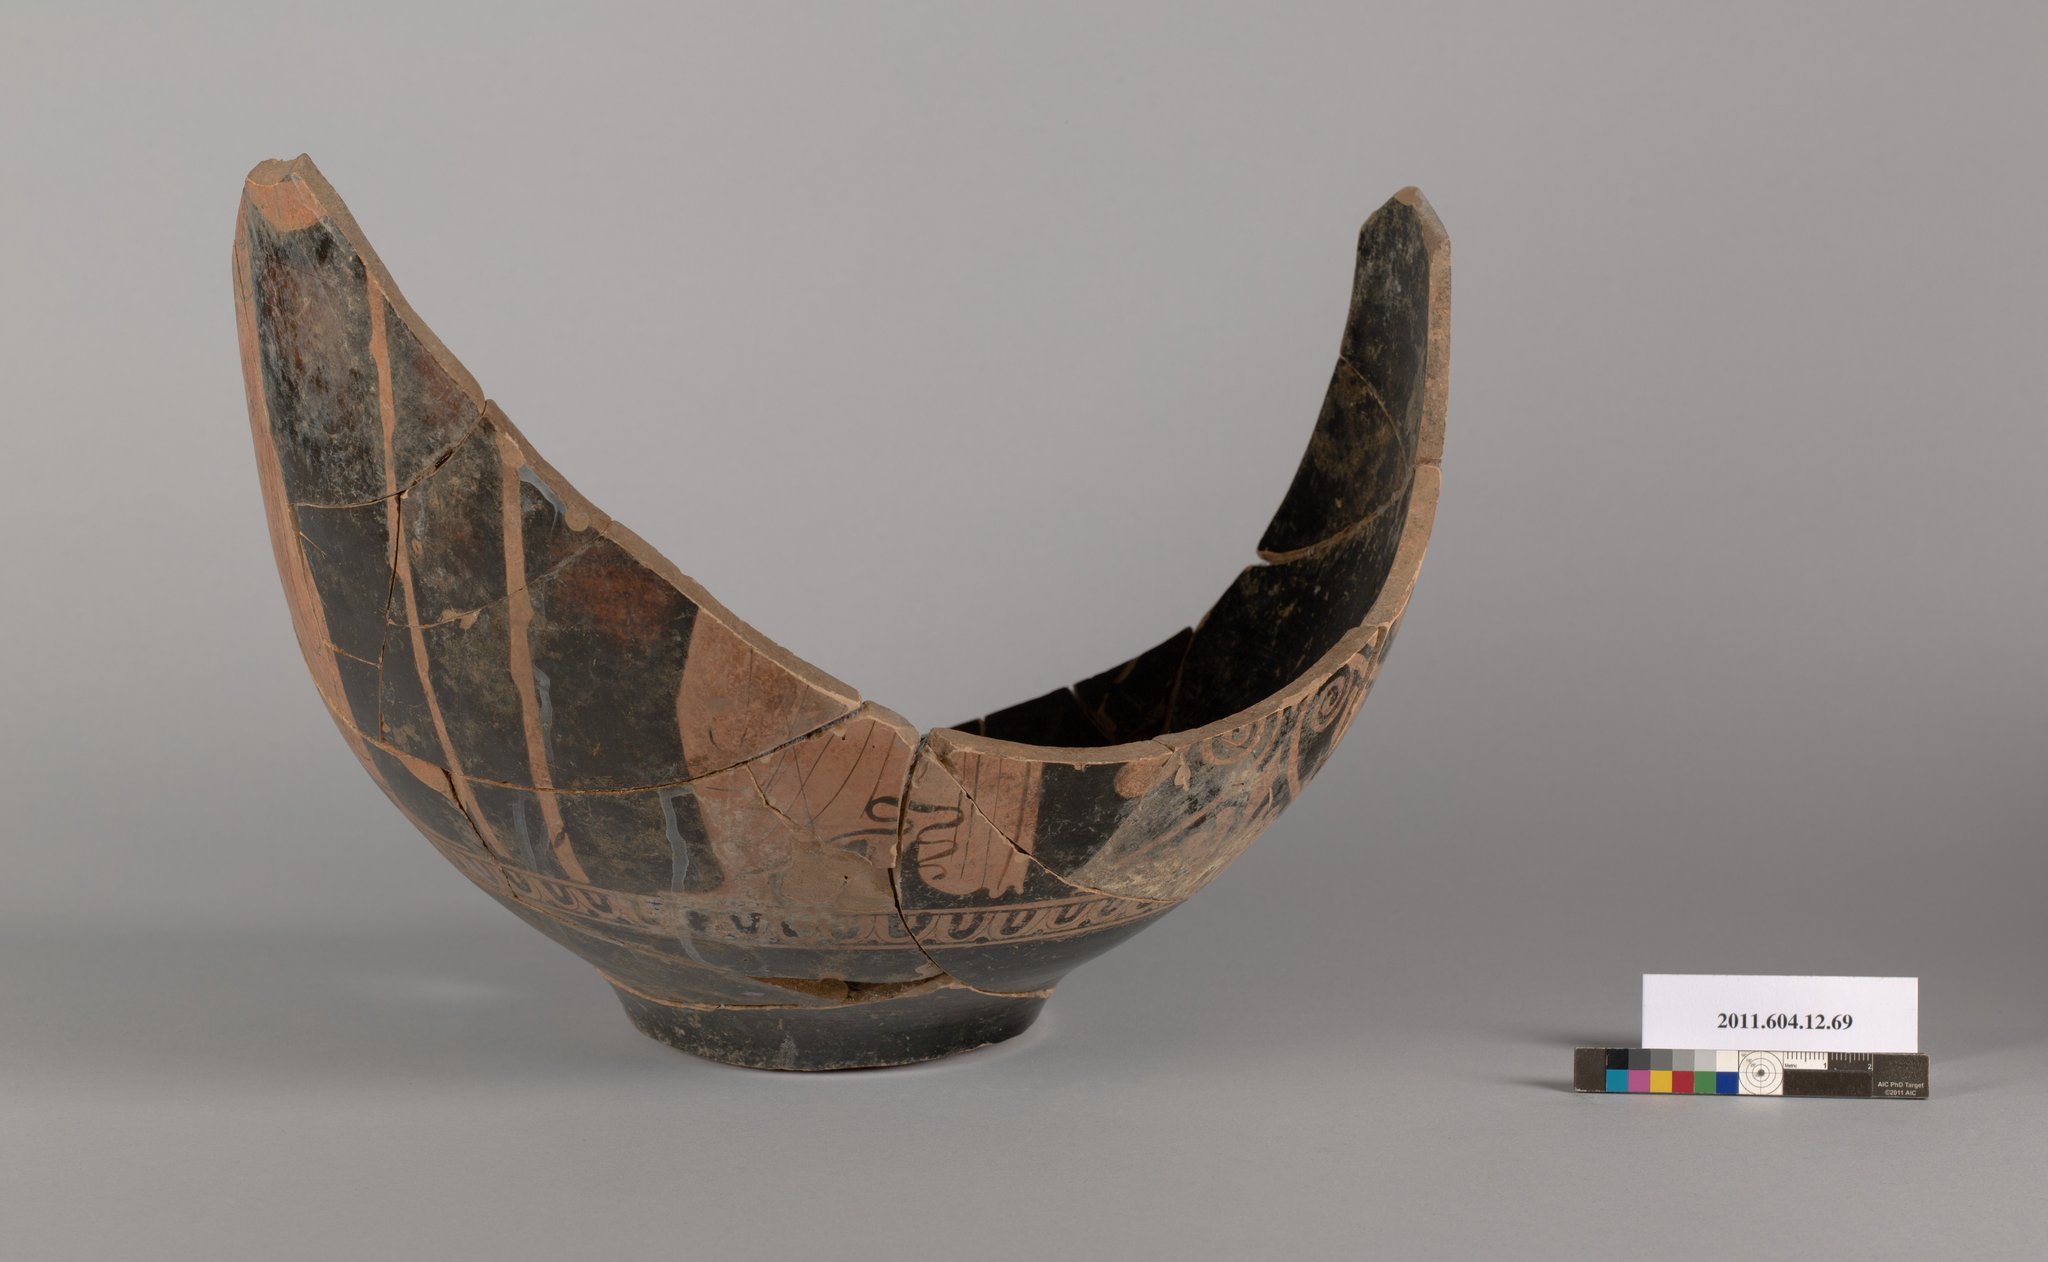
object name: bell krater fragment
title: Terracotta fragment of a bell-krater (deep bowl)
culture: greek, south italian, apulian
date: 350-301 BCE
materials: terracotta